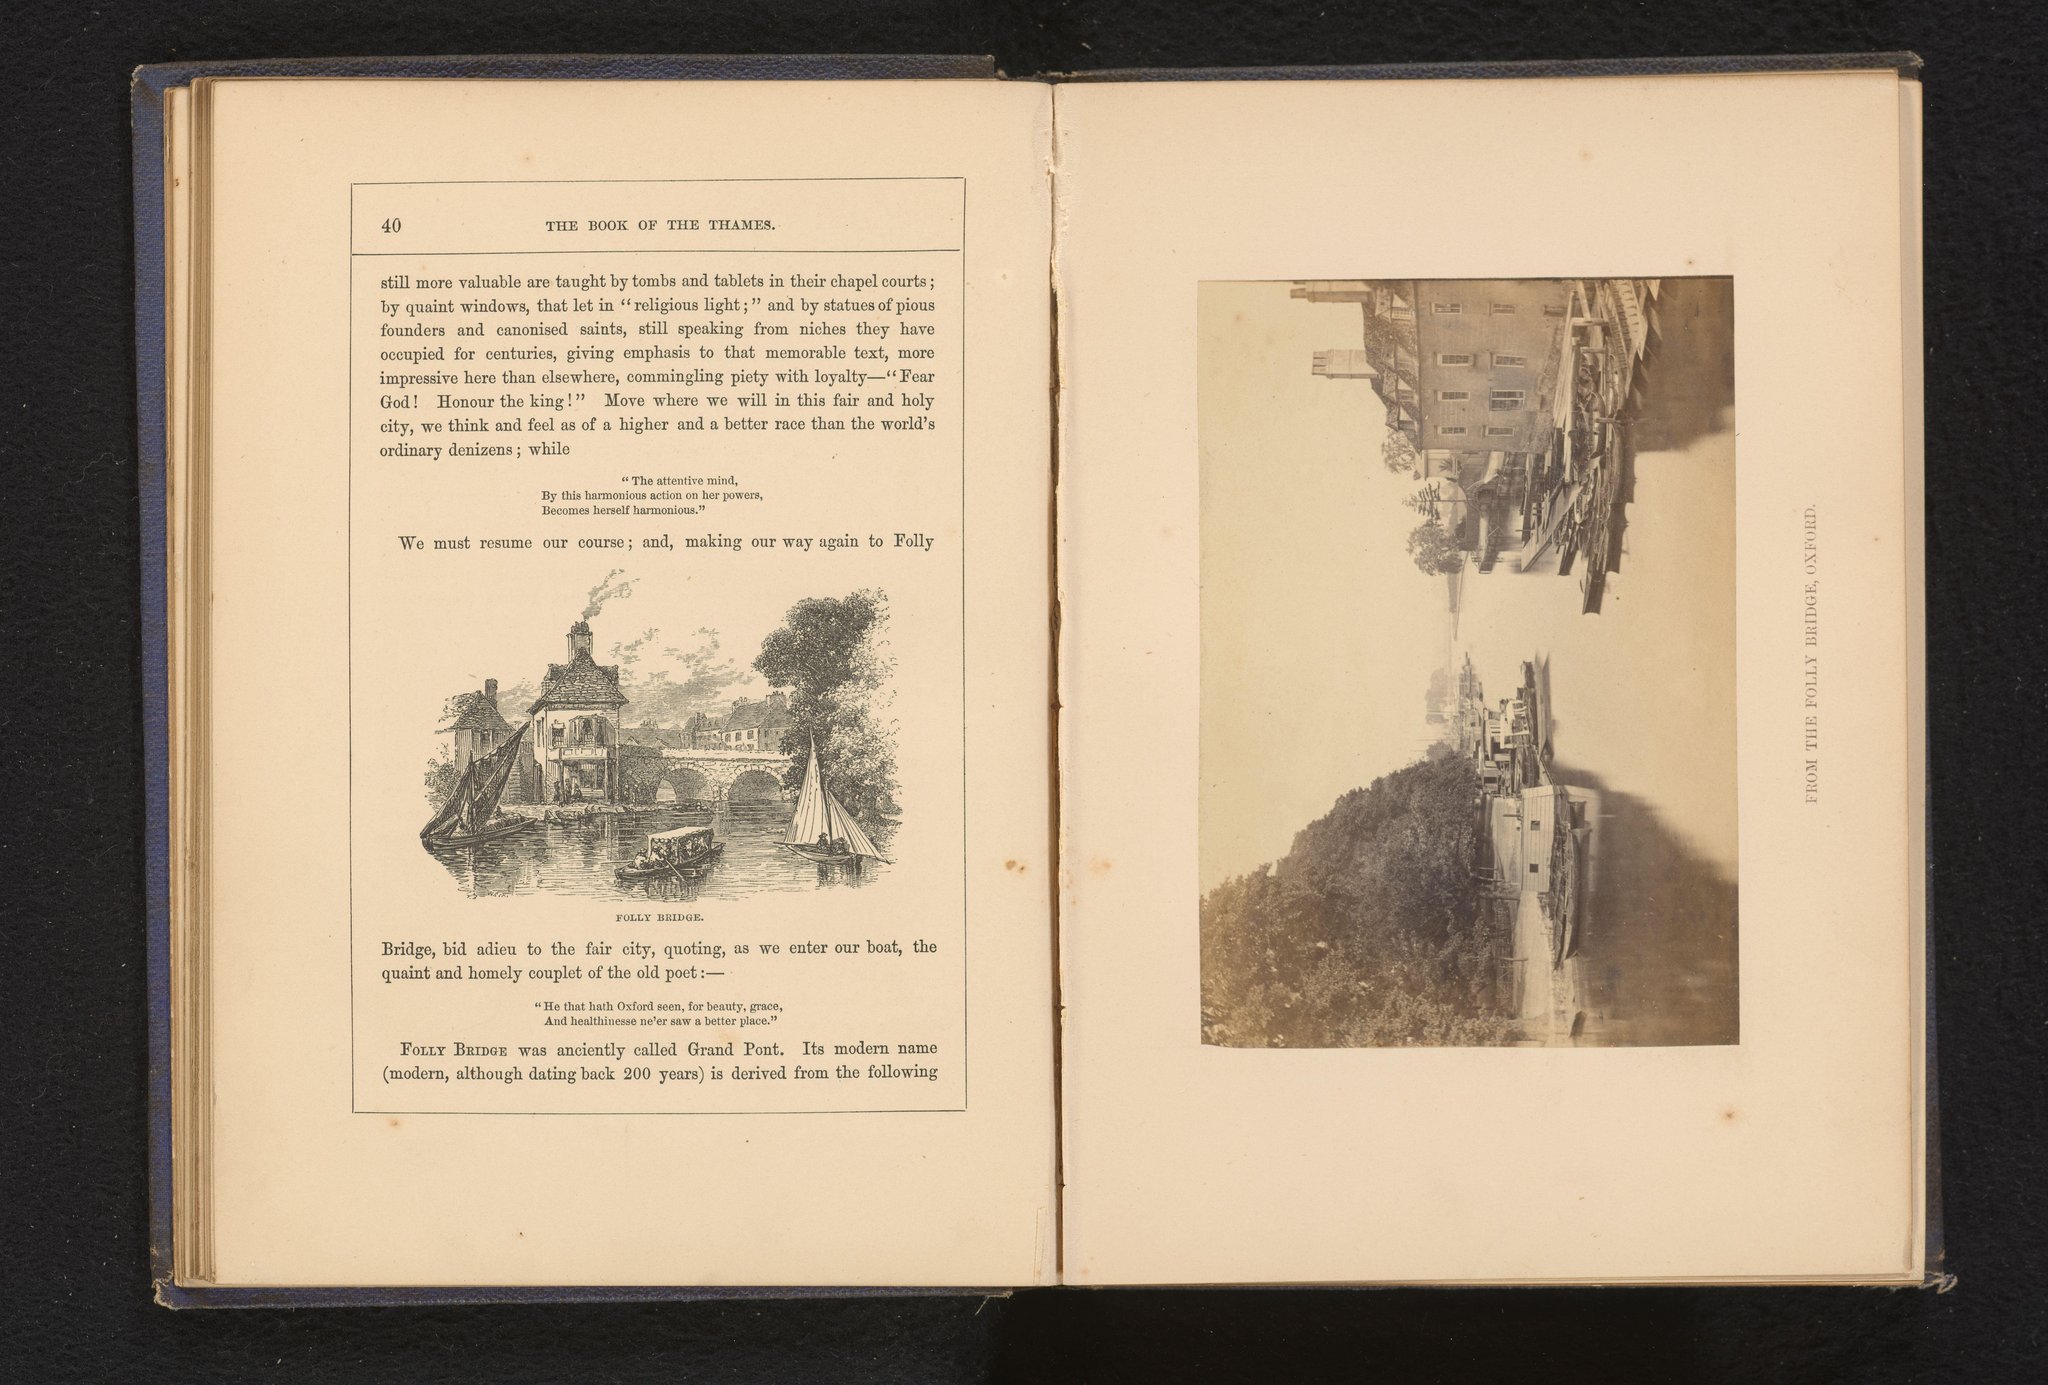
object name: photograph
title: From the Folly Bridge, Oxford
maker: francis frith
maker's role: publisher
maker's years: 1822-1898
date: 1862-1867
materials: paper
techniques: albumen print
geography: oxford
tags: river, thames